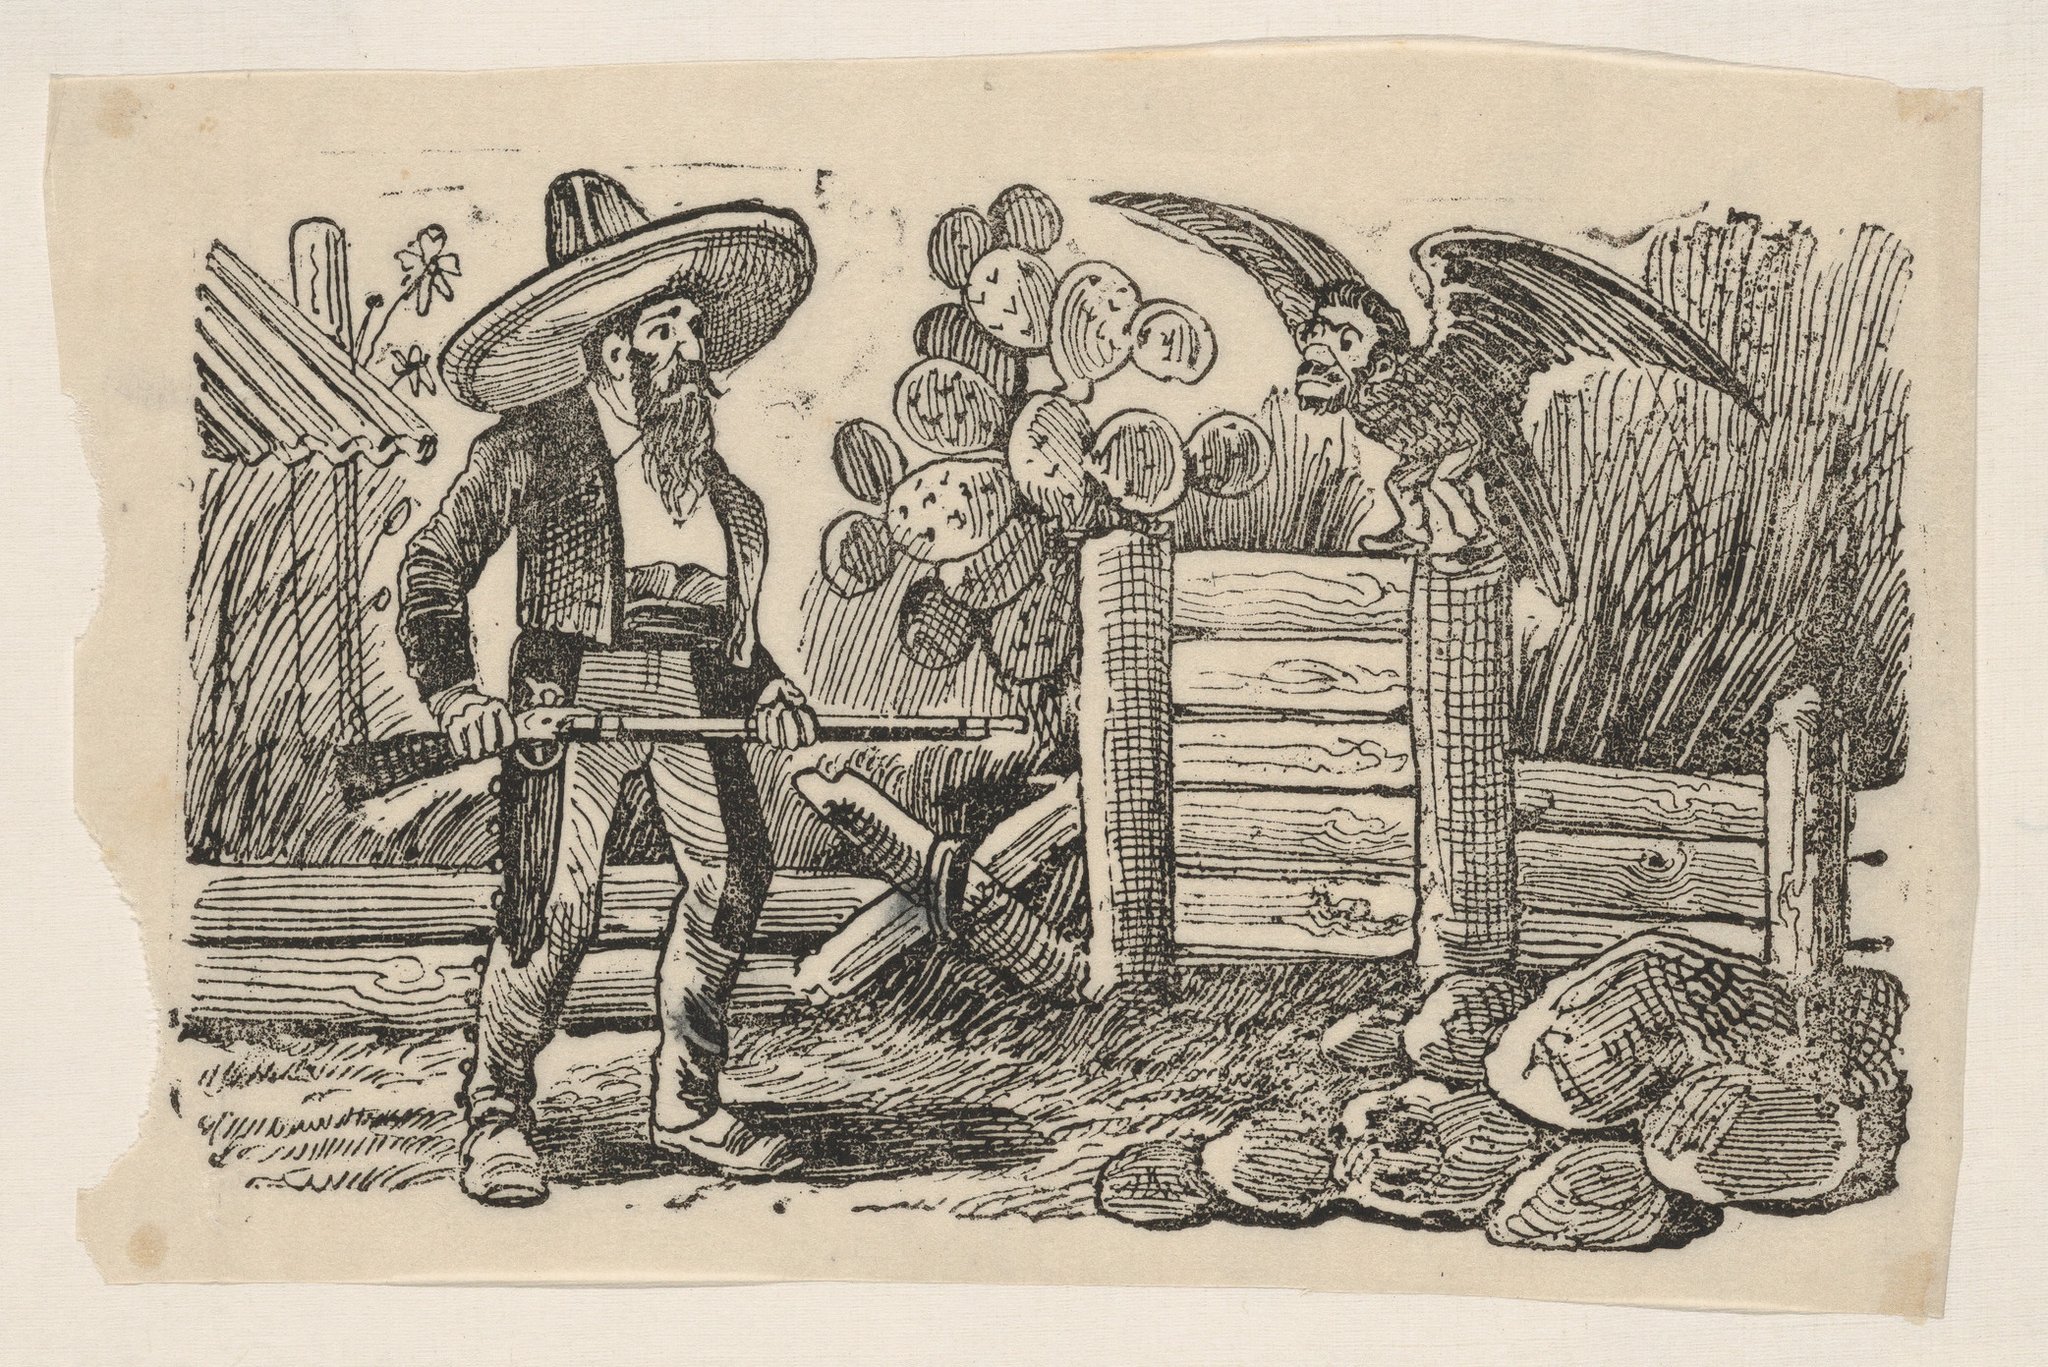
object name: print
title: The Sorcerer, a man with a gun confronting a bird with the face of a man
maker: josé guadalupe posada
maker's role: artist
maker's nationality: mexican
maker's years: 1852-1913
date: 1900-1910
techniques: lithography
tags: firearms,men